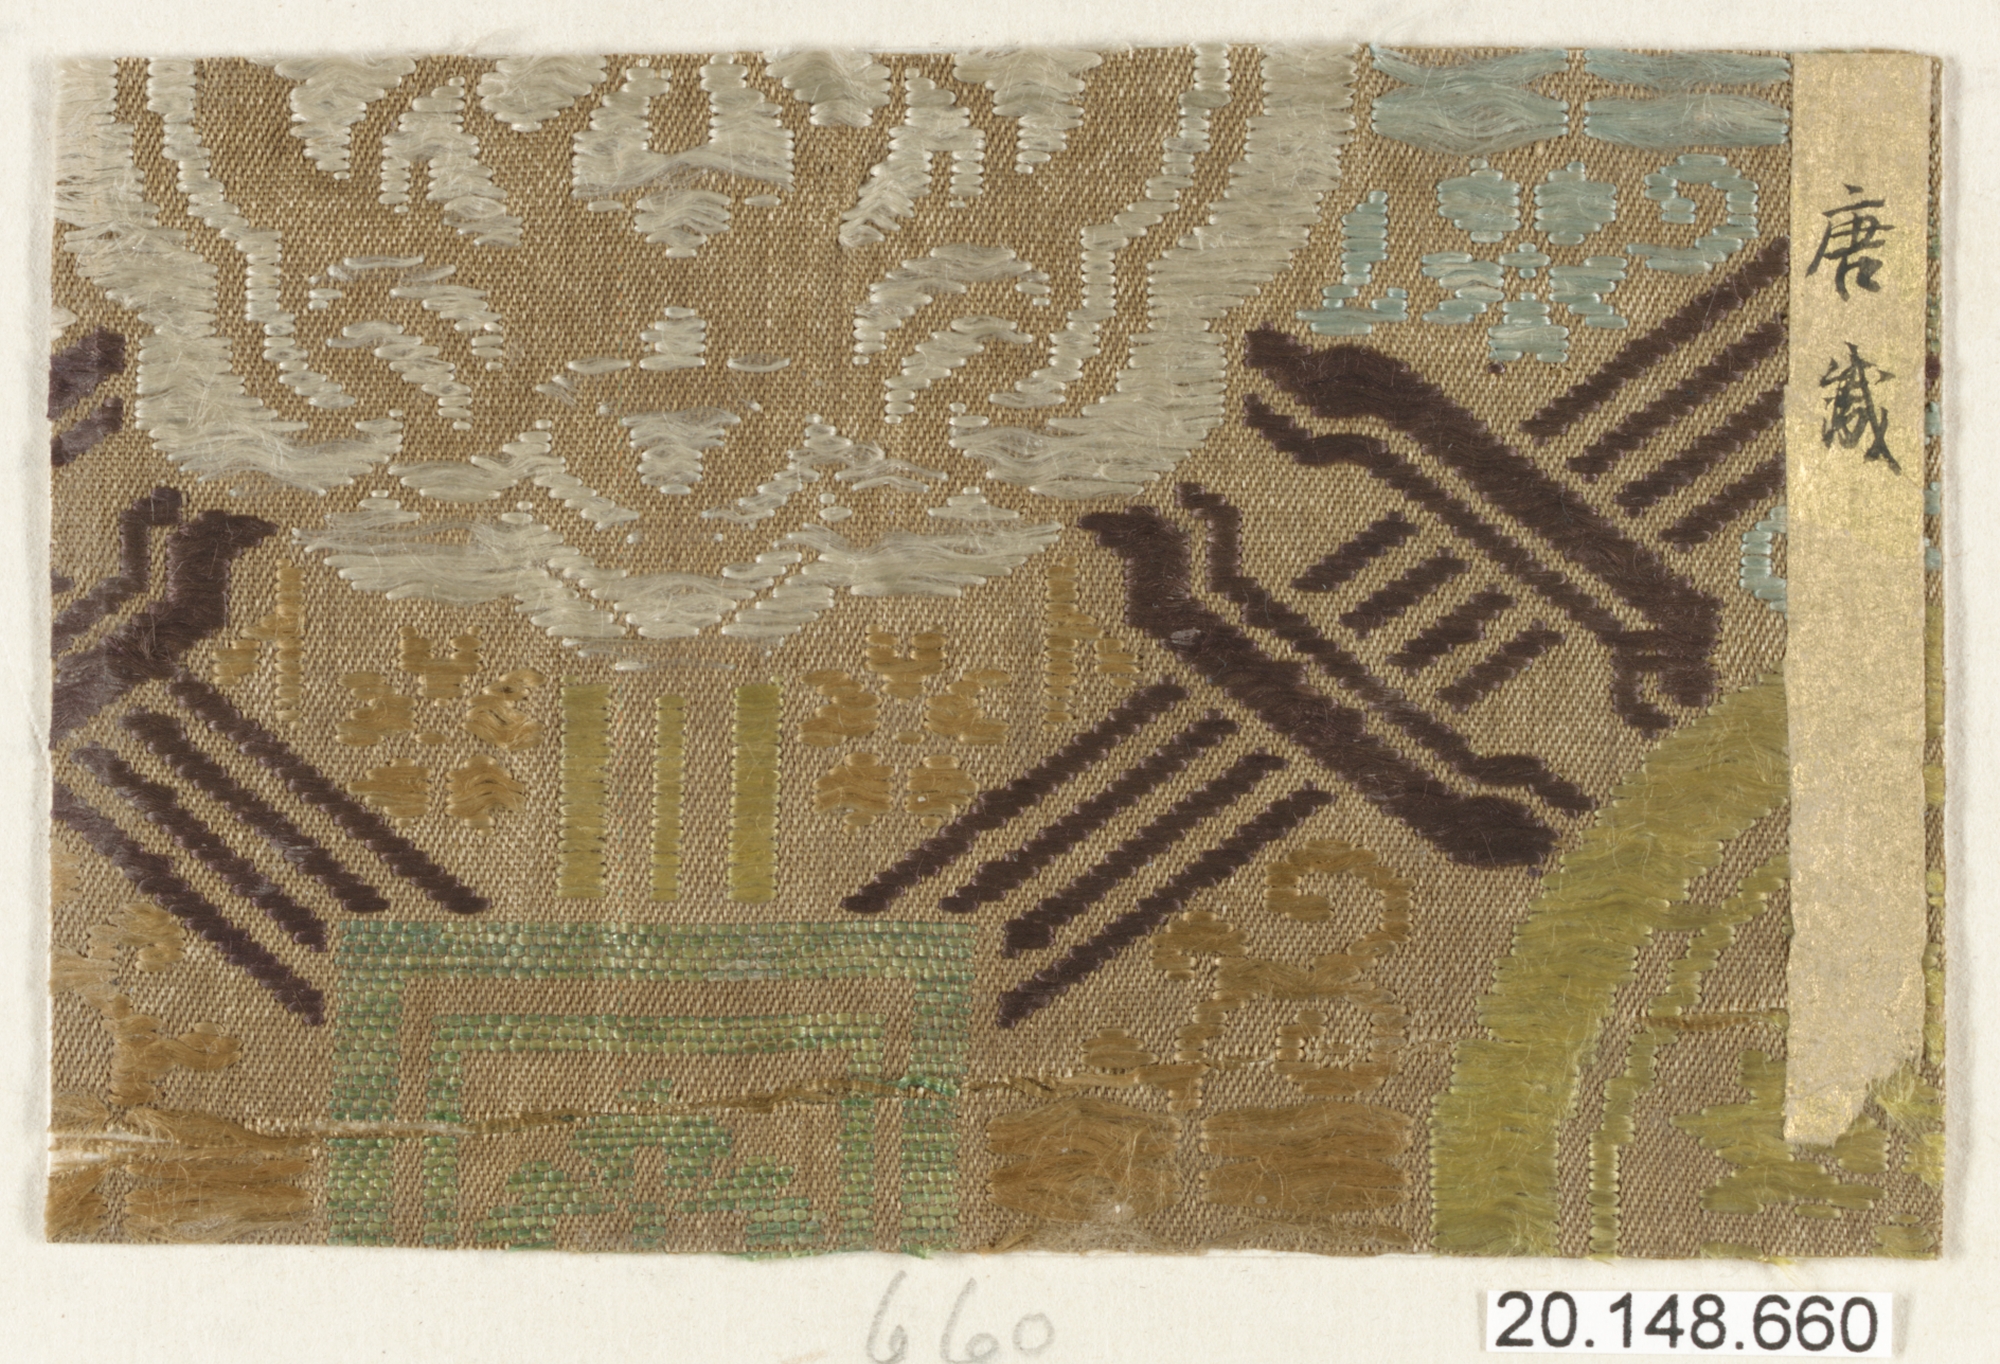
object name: piece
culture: japanese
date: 1601-1700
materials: silk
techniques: compound weave